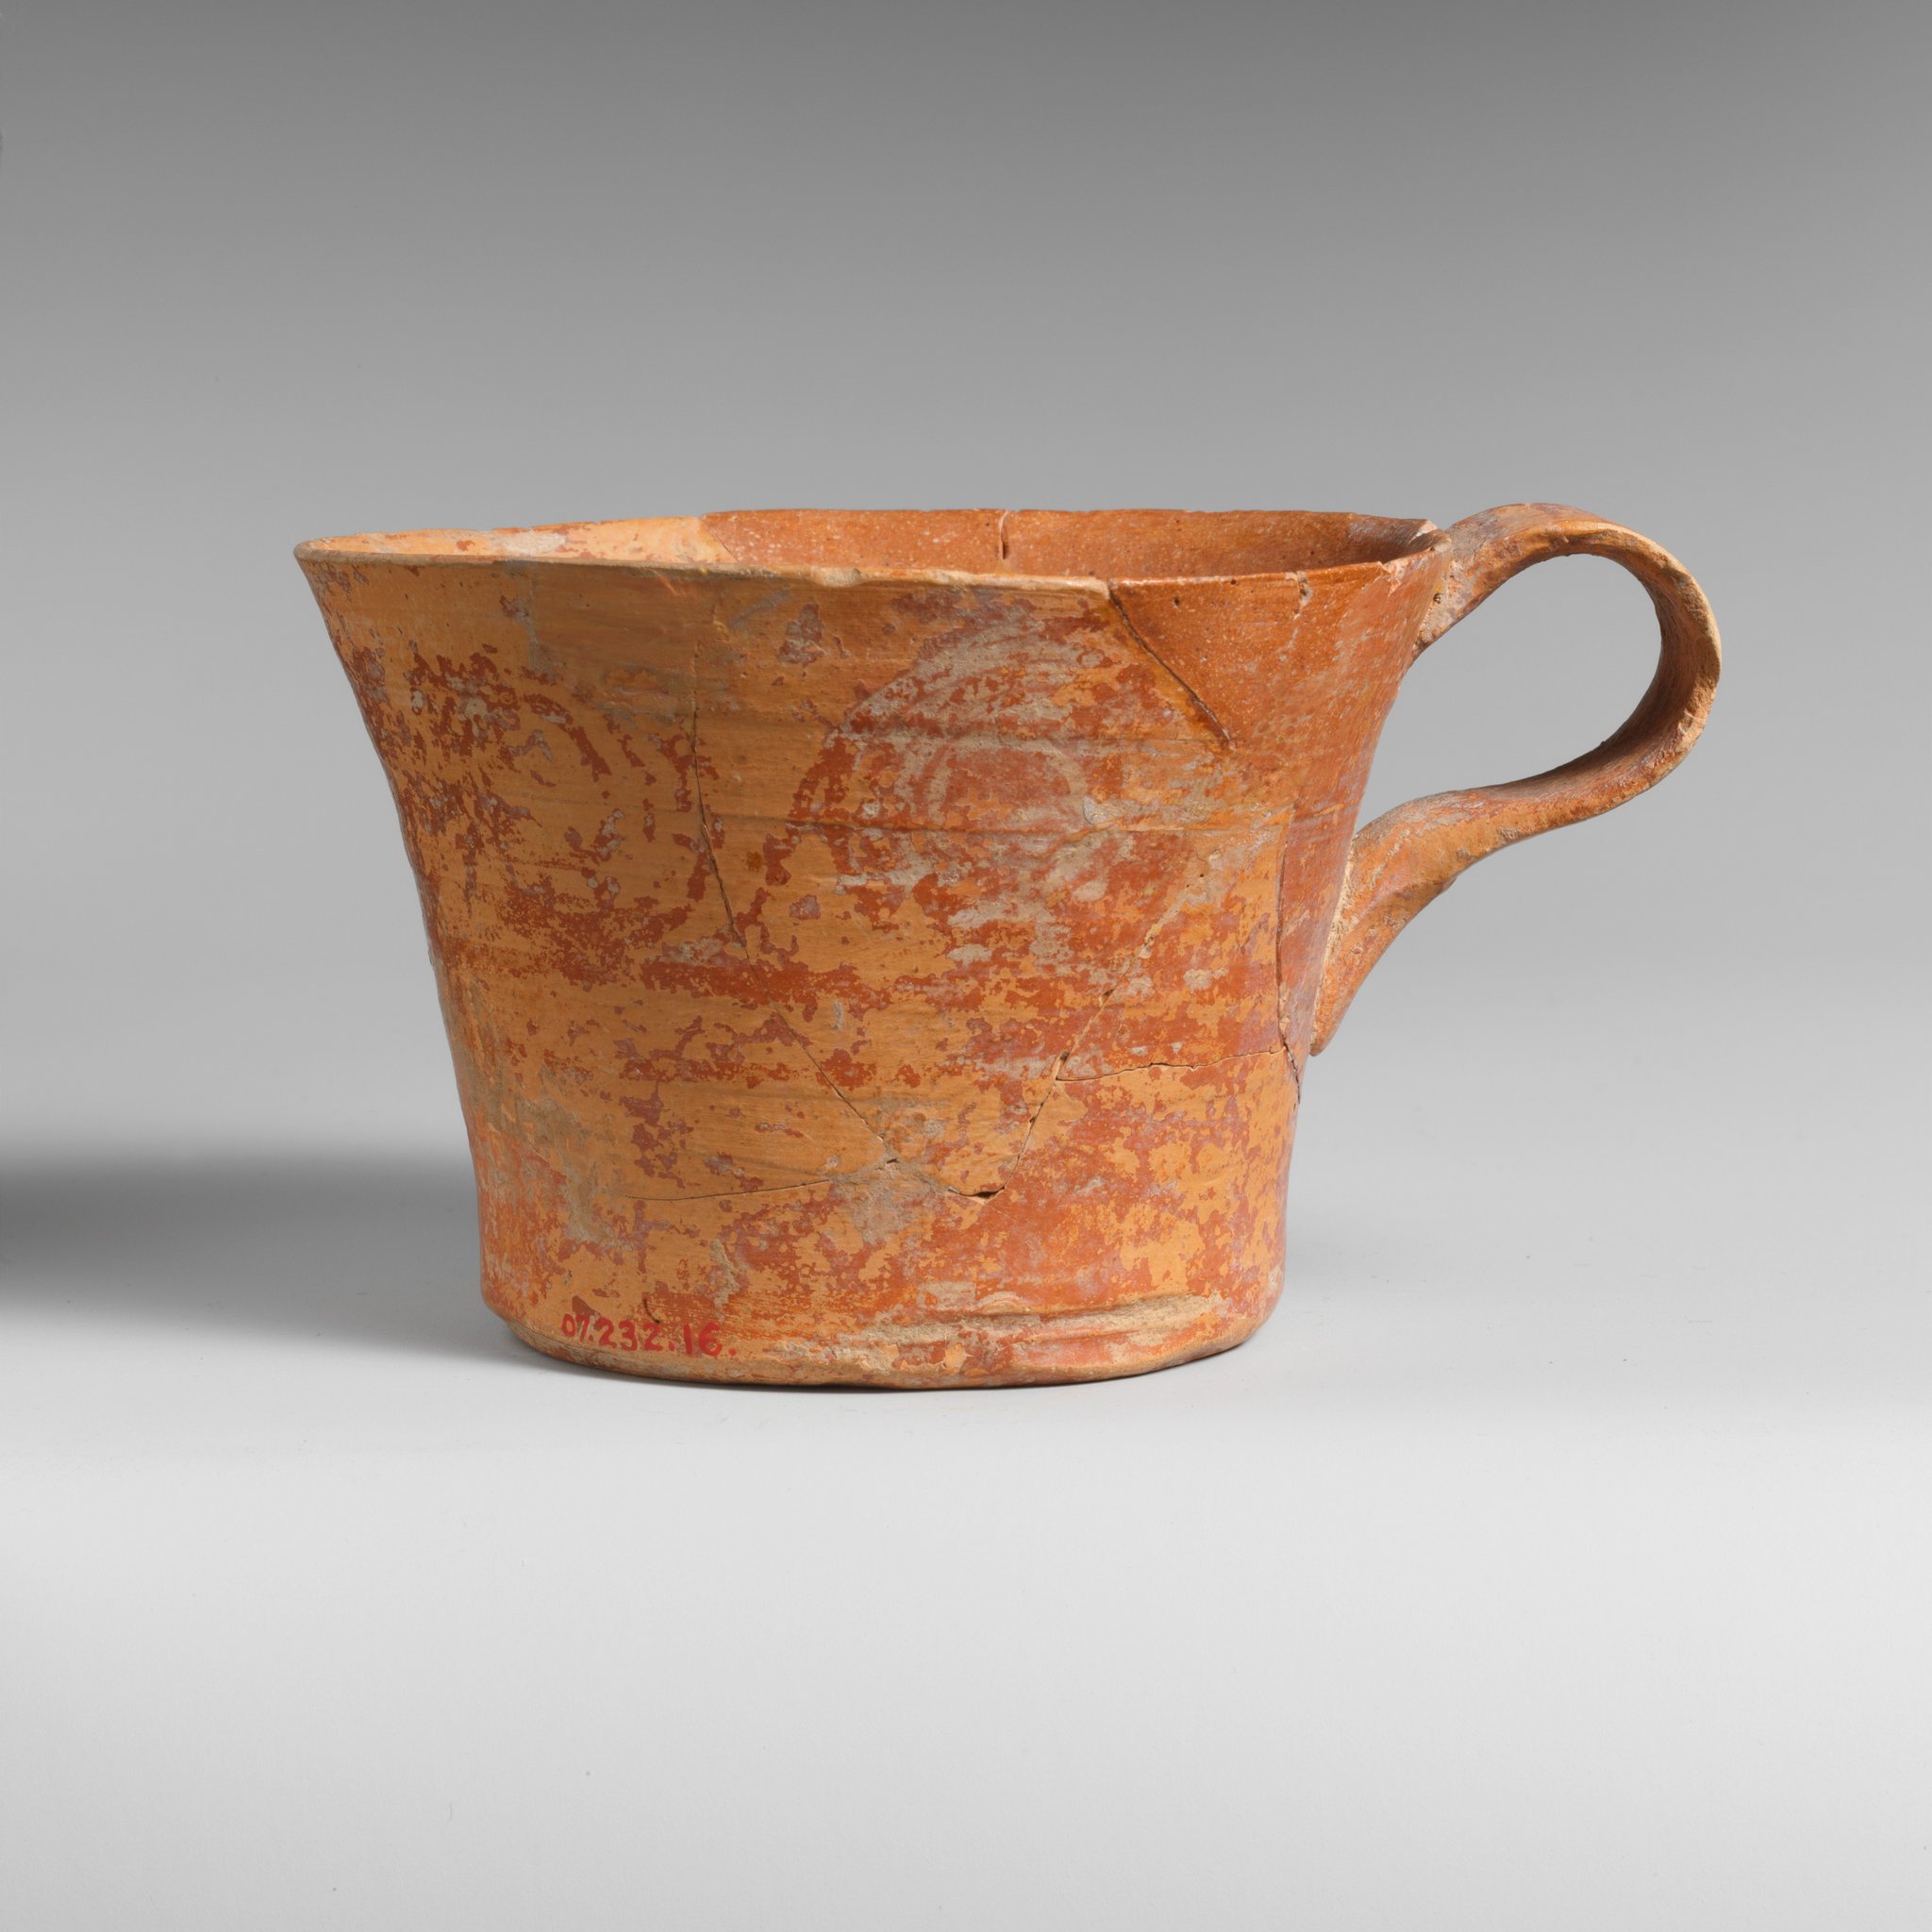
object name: cup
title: Terracotta straight-sided cup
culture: minoan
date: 1750-1600 BCE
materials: terracotta